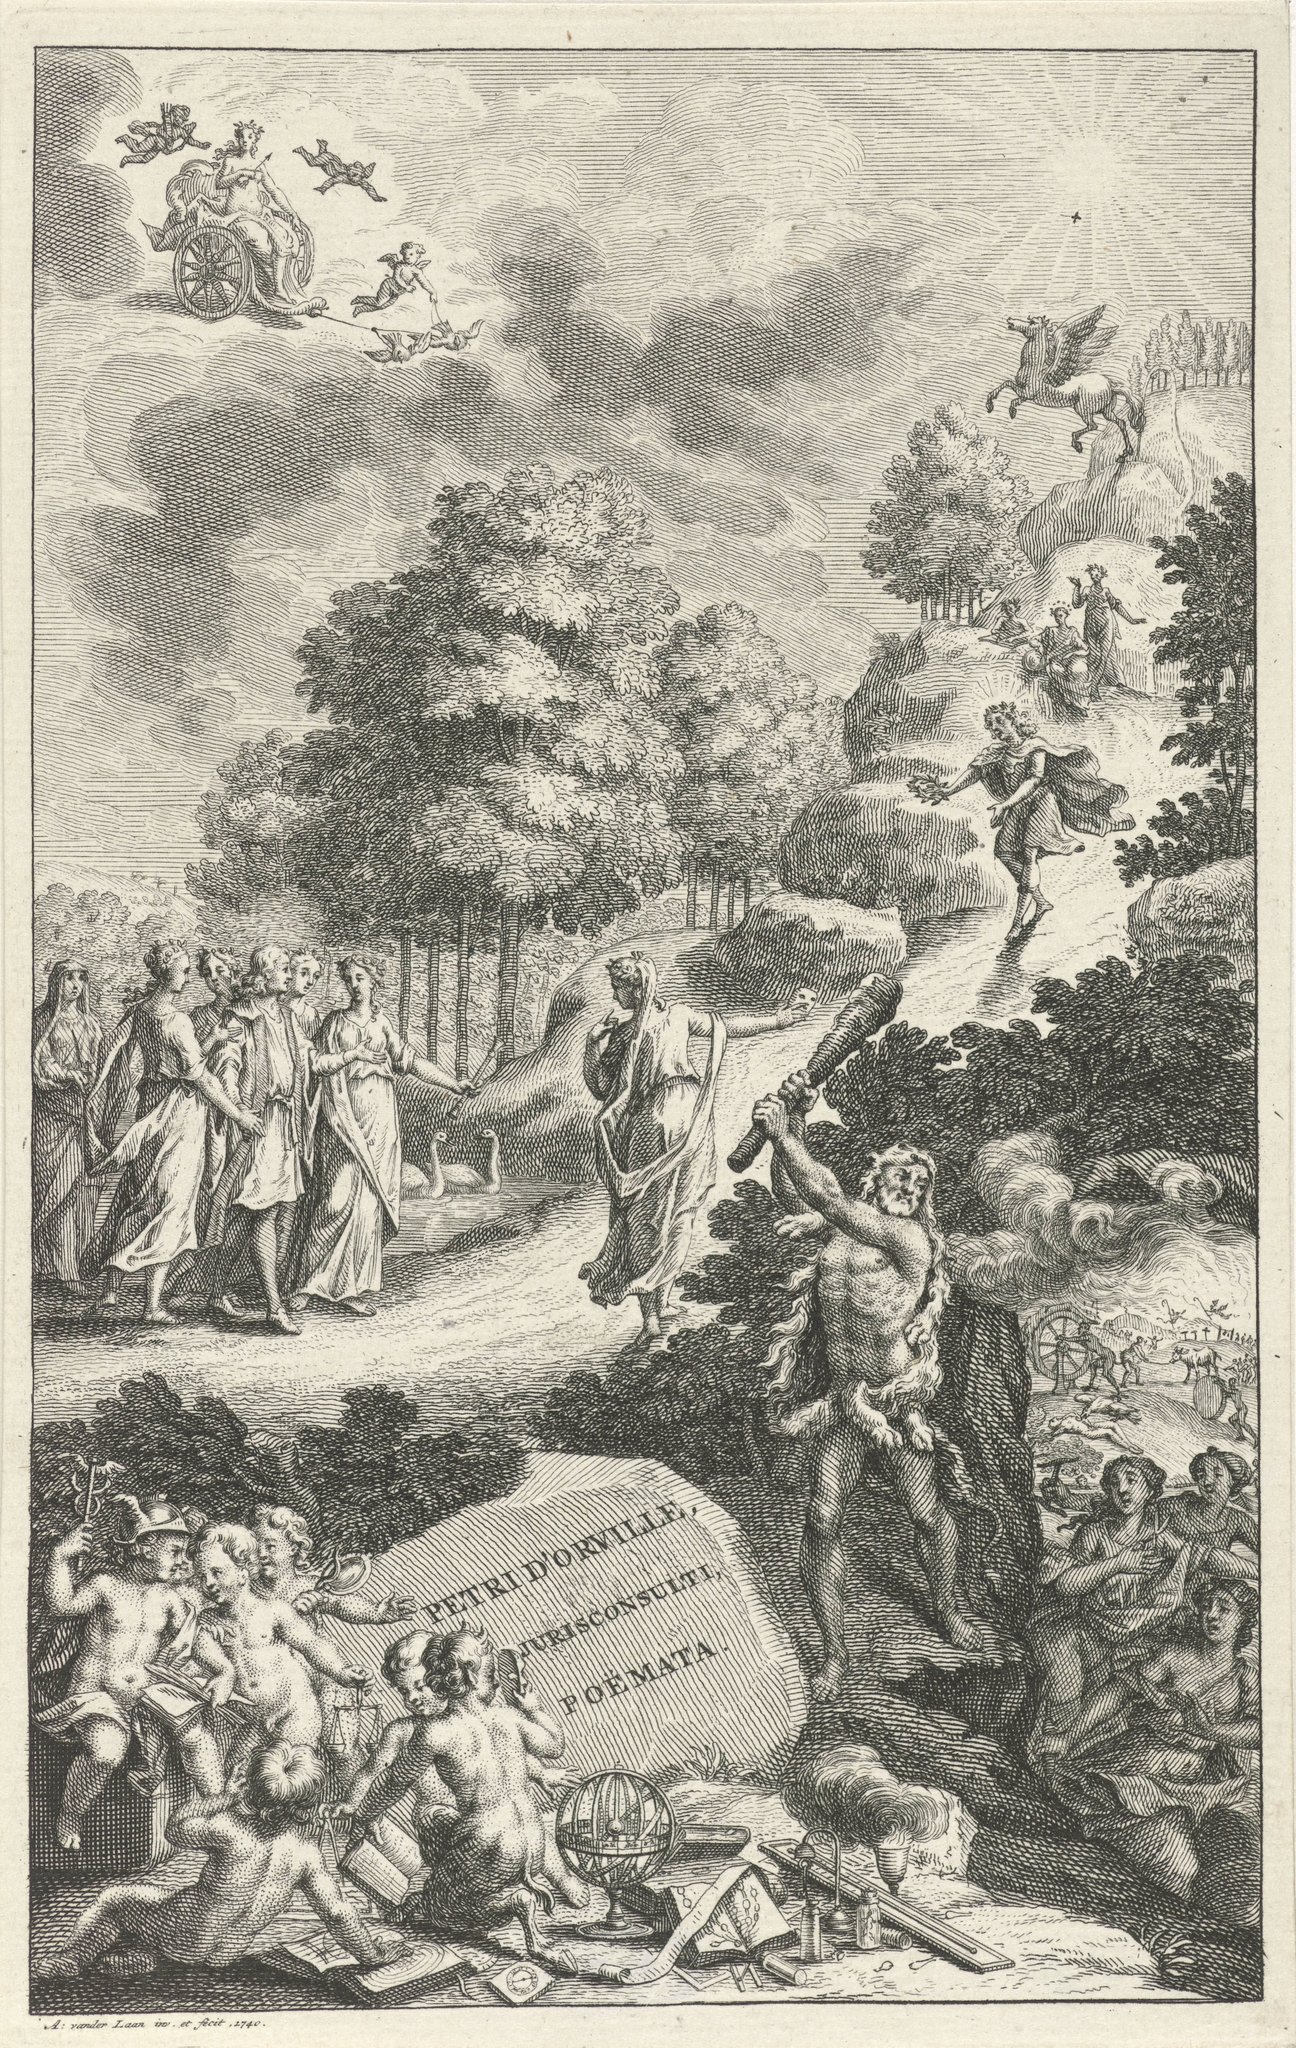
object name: titelblad, titelpagina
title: Apollo daalt af van de Parnassus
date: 1740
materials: paper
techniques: etching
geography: amsterdam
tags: (story of) hercules (heracles), pegasus, the winged horse, apollo and the muses, apollo musagetes, cupids together with attributes of the arts, sciences, etc., parnassus, sacred to apollo musagetes, tartarus (and the condemned assigned there)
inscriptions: collector's mark: Lugt 2228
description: Een man omringd door muzen kijkt toe hoe Apollo afdaalt van de Parnassus om hem te lauweren. Op de Parnassus bevinden zich drie muzen en een steigerende Pegasus. Op de voorgrond putti met attributen van wetenschap en kunsten, rechts haalt Hercules met zijn knots uit naar de drie schikgodinnen die voor de ingang van de Tartarus zitten. In de lucht wordt Venus, in het gezelschap van putti, op haar zegekar voortgetrokken door twee duiven.